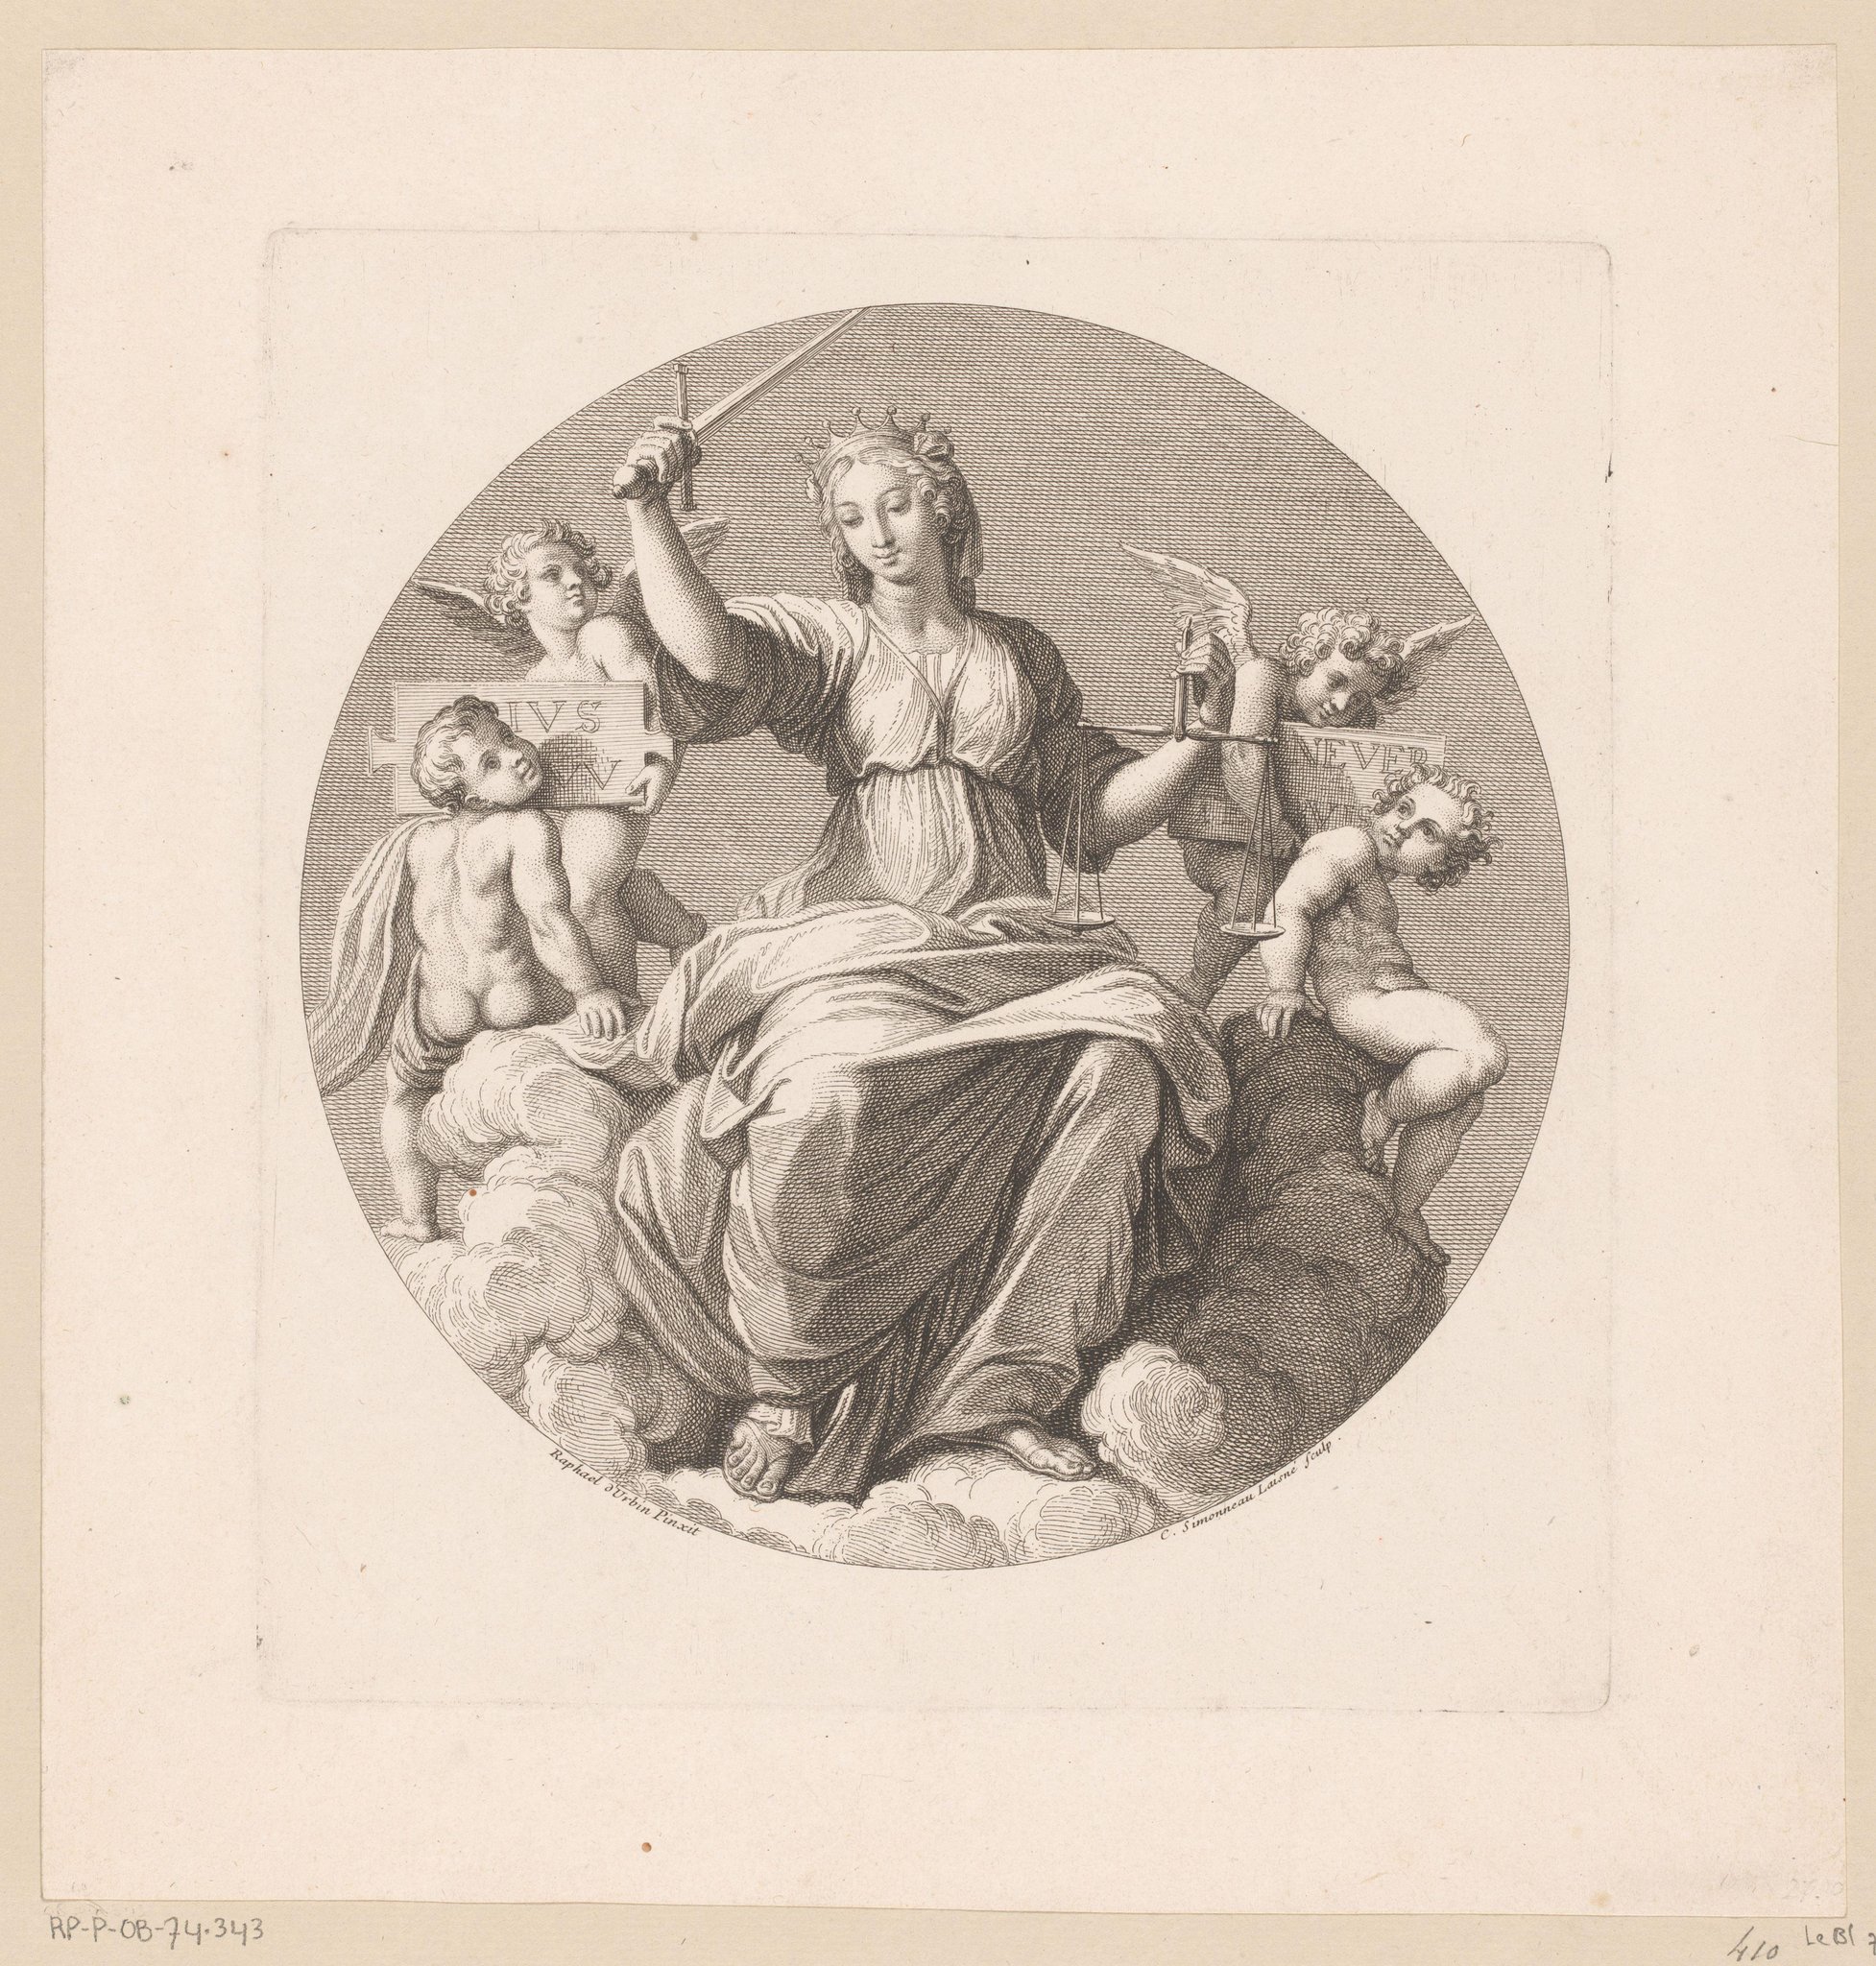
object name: print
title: Gerechtigheid omringd door vier putti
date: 1655-1728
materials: paper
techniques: engraving, etching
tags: justice, 'justitia'; 'giustitia divina' (ripa) ~ one of the four cardinal virtues, cupids: 'amores', 'amoretti', 'putti'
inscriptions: collector's mark: Lugt 240